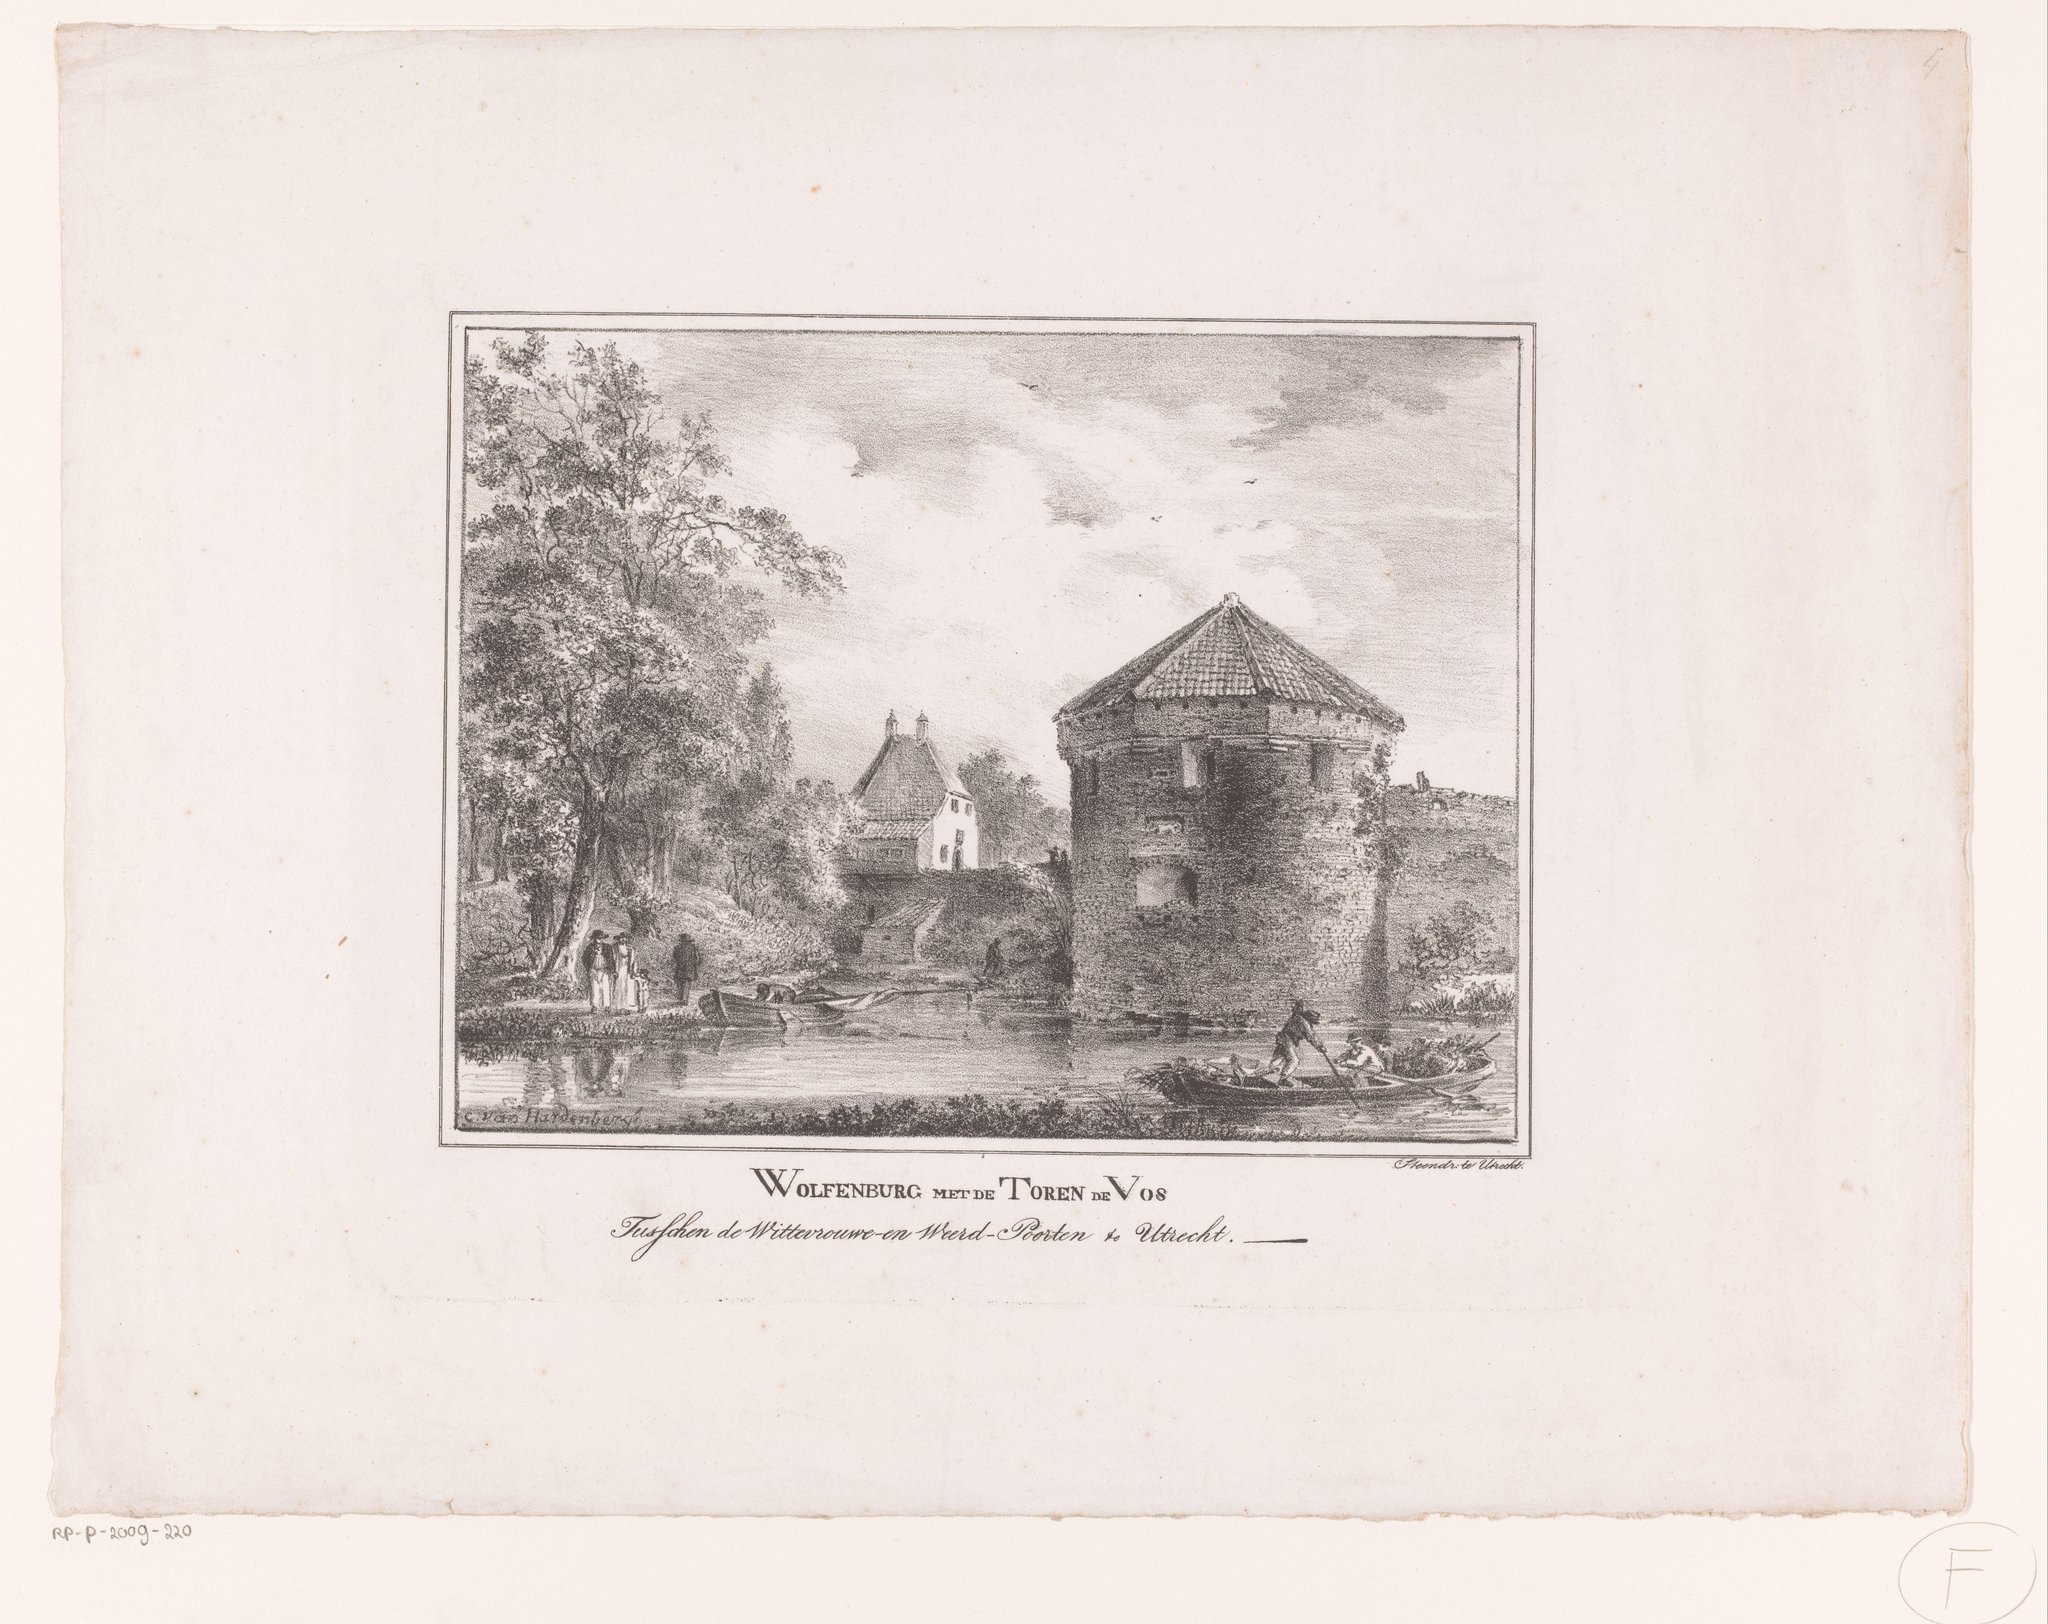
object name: print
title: Wolfenburg met de toren De Vos te Utrecht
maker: cornelis van hardenbergh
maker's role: draughtsman, painter, print maker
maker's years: 1755-1843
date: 1809-1843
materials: paper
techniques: lithograph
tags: towers ~ fortified city, city-walls, utrecht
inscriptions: collector's mark: Lugt 2760, collector's mark: Lugt 2228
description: Landschap met gezicht op de Toren de Vos tussen de Wittevrouwenpoort en de Weerdpoort te Utrecht. Links hiervan een beboste oever met wandelende figuren en een bootje. Op de voorgrond een rivier met rechts twee mannen in een boot.